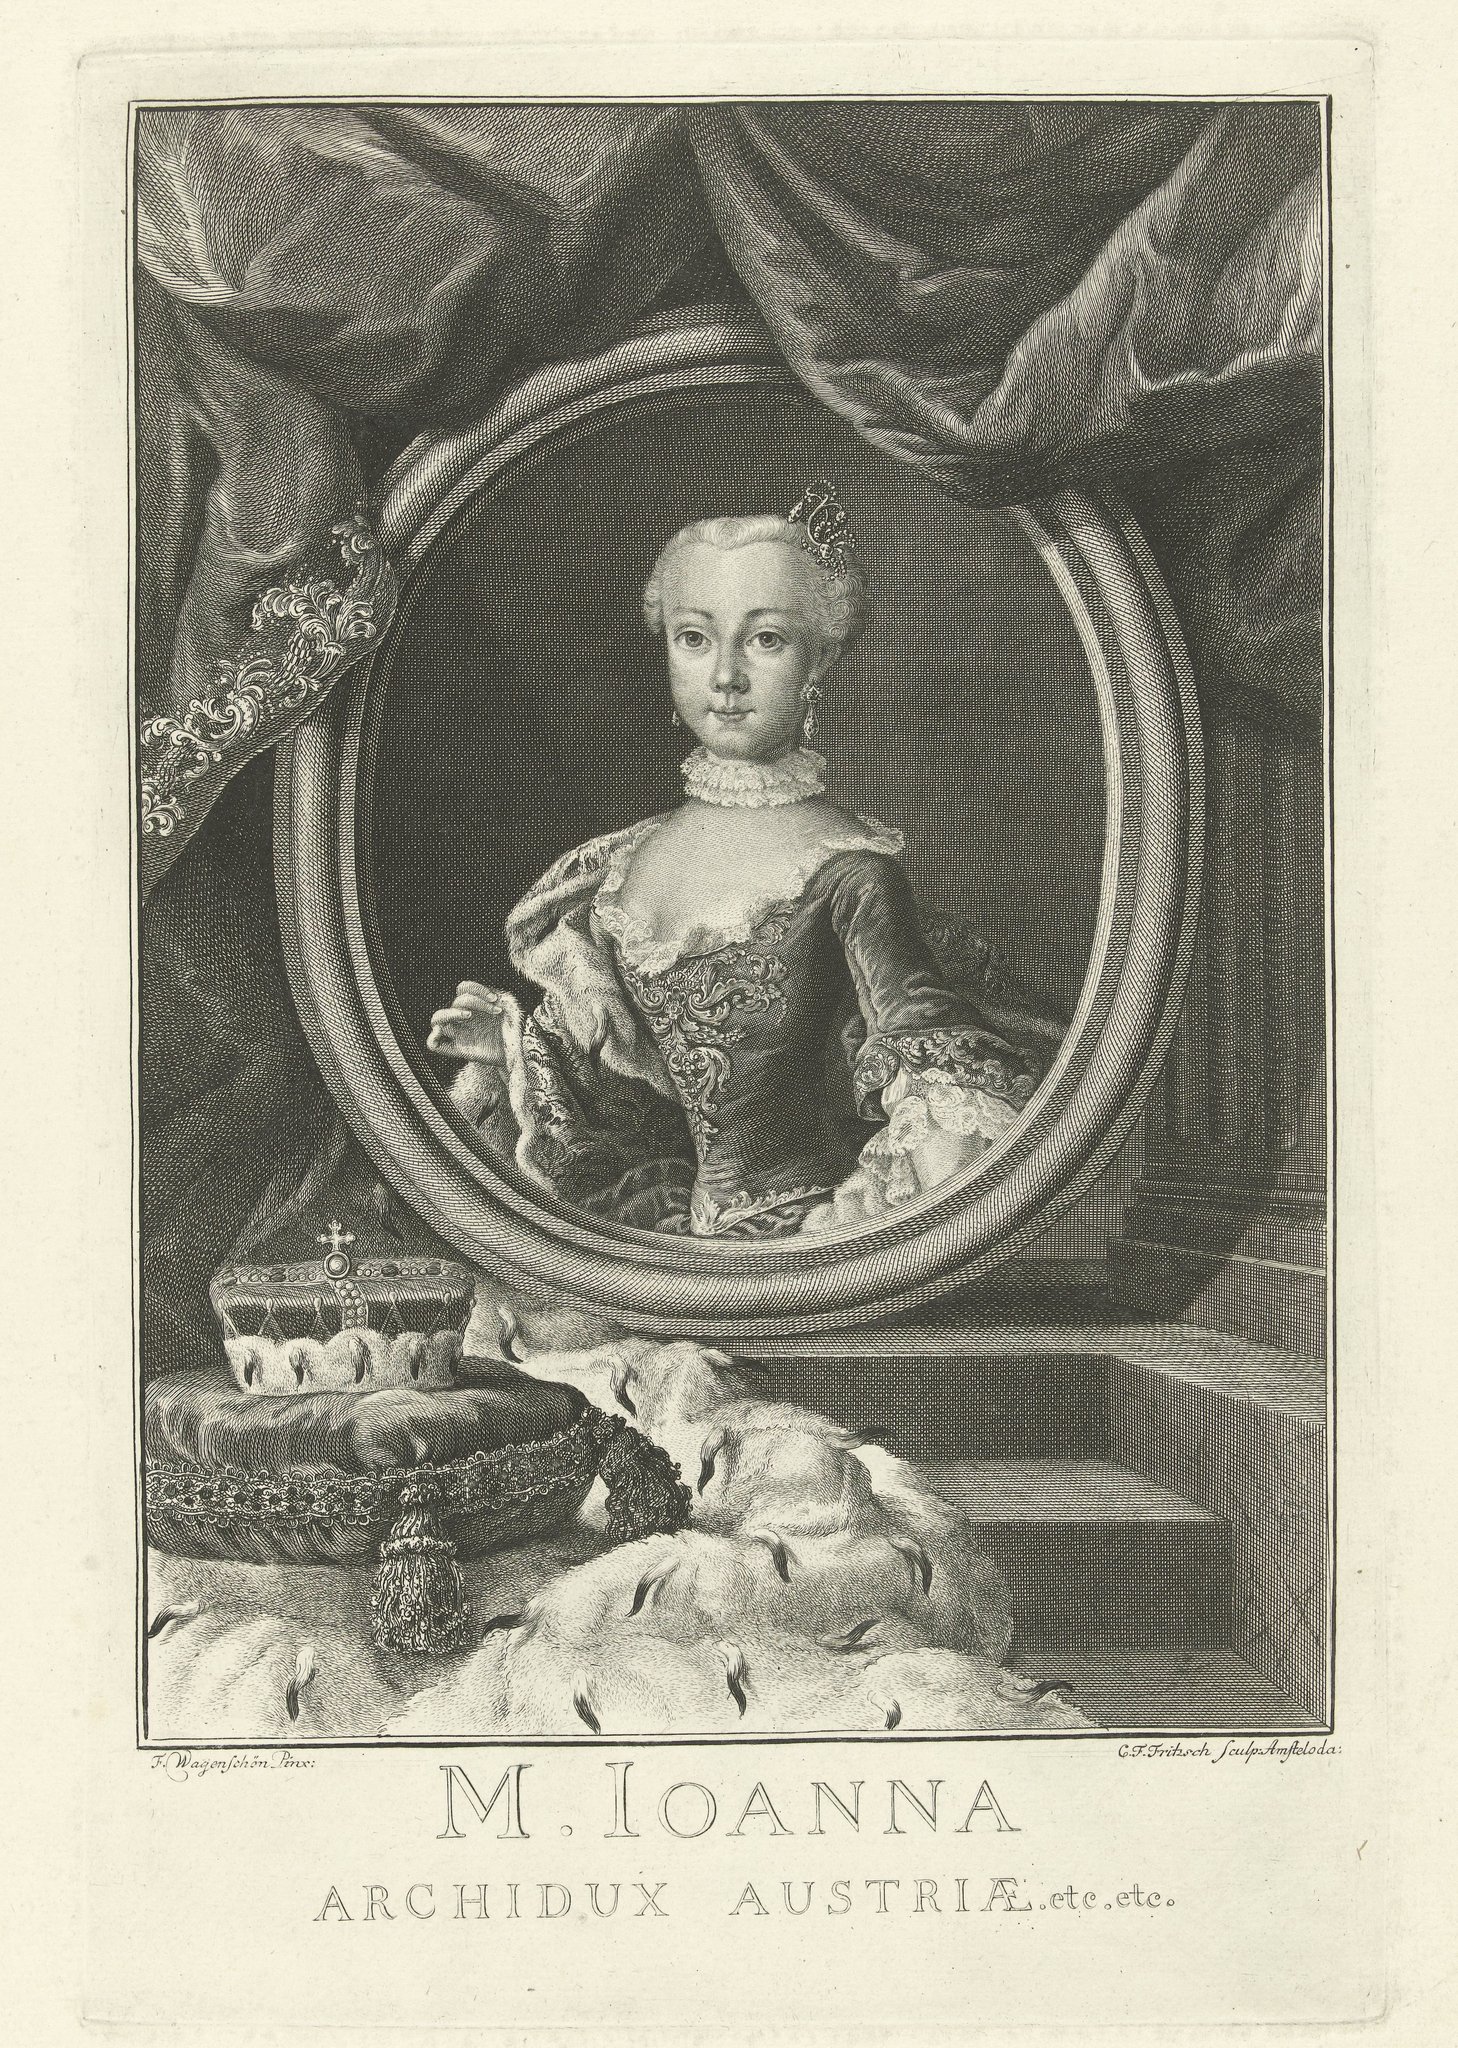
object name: print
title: M. Ioanna. Archidux Austriae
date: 1750-1762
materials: paper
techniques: engraving, etching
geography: amsterdam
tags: vienna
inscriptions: collector's mark: Lugt 2228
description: Portret in ovaal van Johanna Gabriella, aartshertogin van Oostenrijk, ten halven lijve naar links. In het haar is een sierspeld gestoken. Links voor het portret ligt een kroon op een kussen.